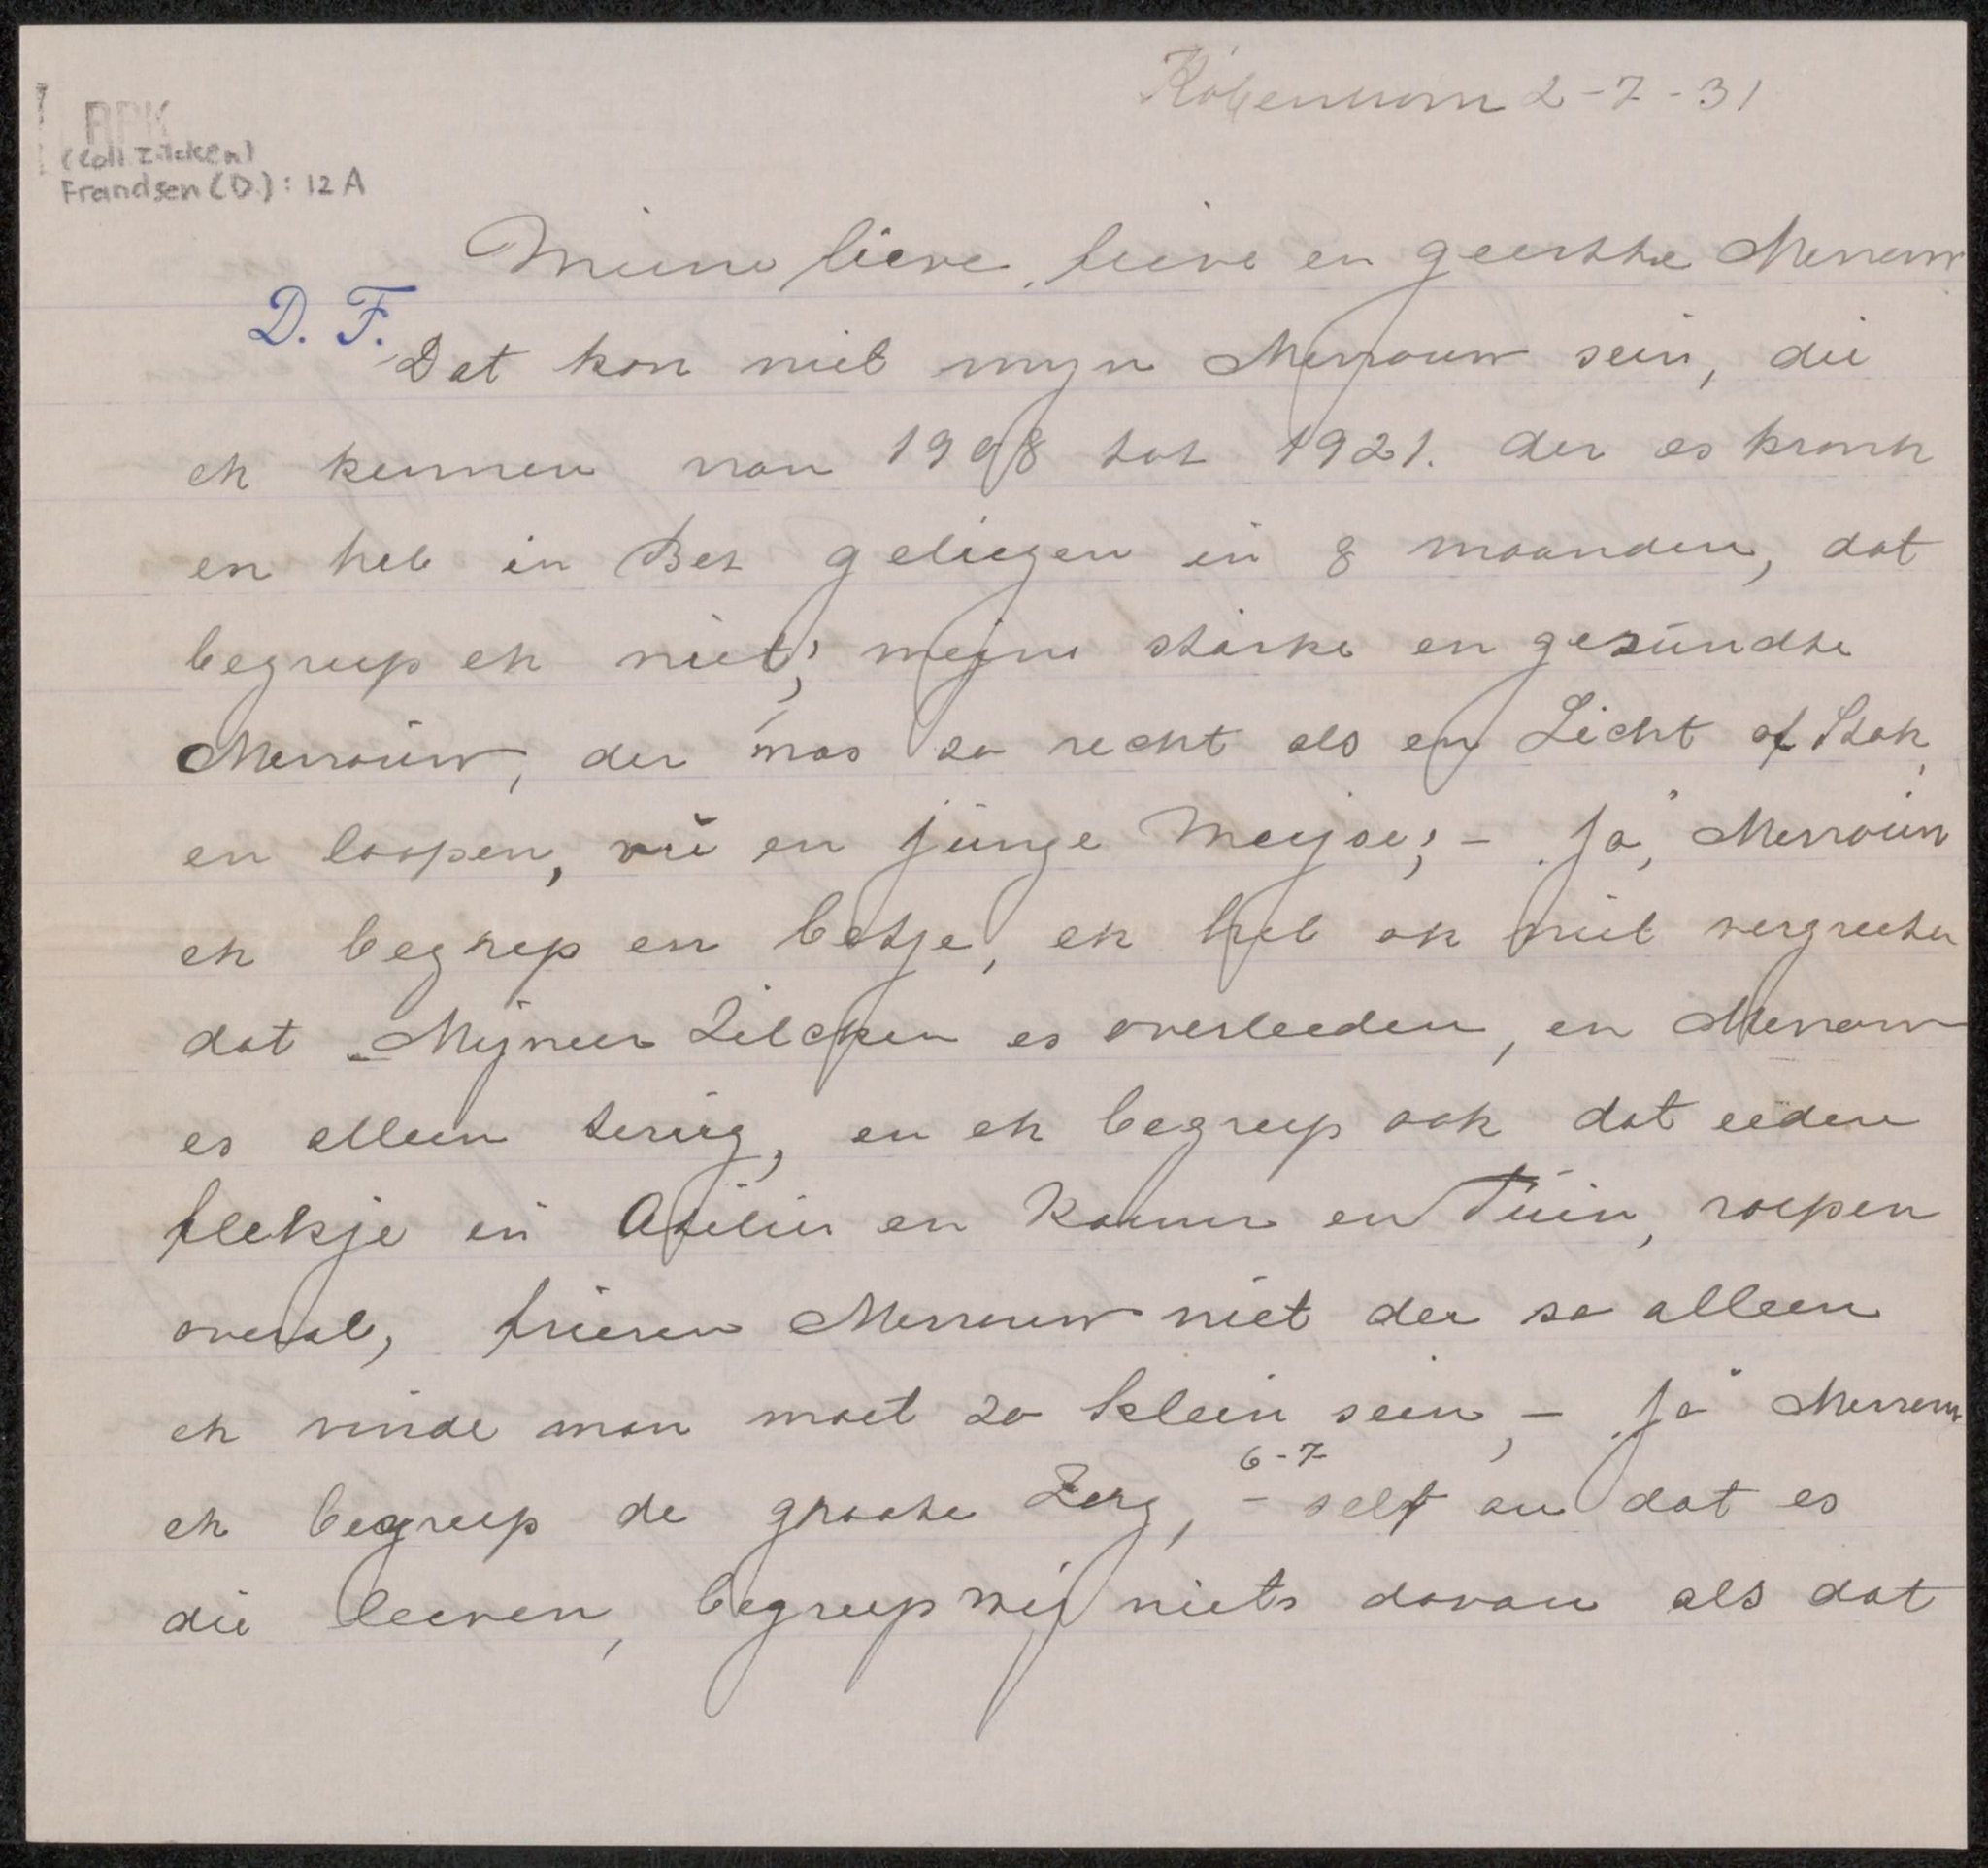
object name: letter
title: Brief aan Henriette Wilhelmina van Baak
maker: dagmar frandsen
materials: ink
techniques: pen, writing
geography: copenhagen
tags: henriette wilhelmina van baak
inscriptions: collector's mark: ‘RPK’, initials: ‘D.F.’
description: Vormt samen met RP-D-1982-43-FRANDSEN(D.)-12B een doorlopende brief.